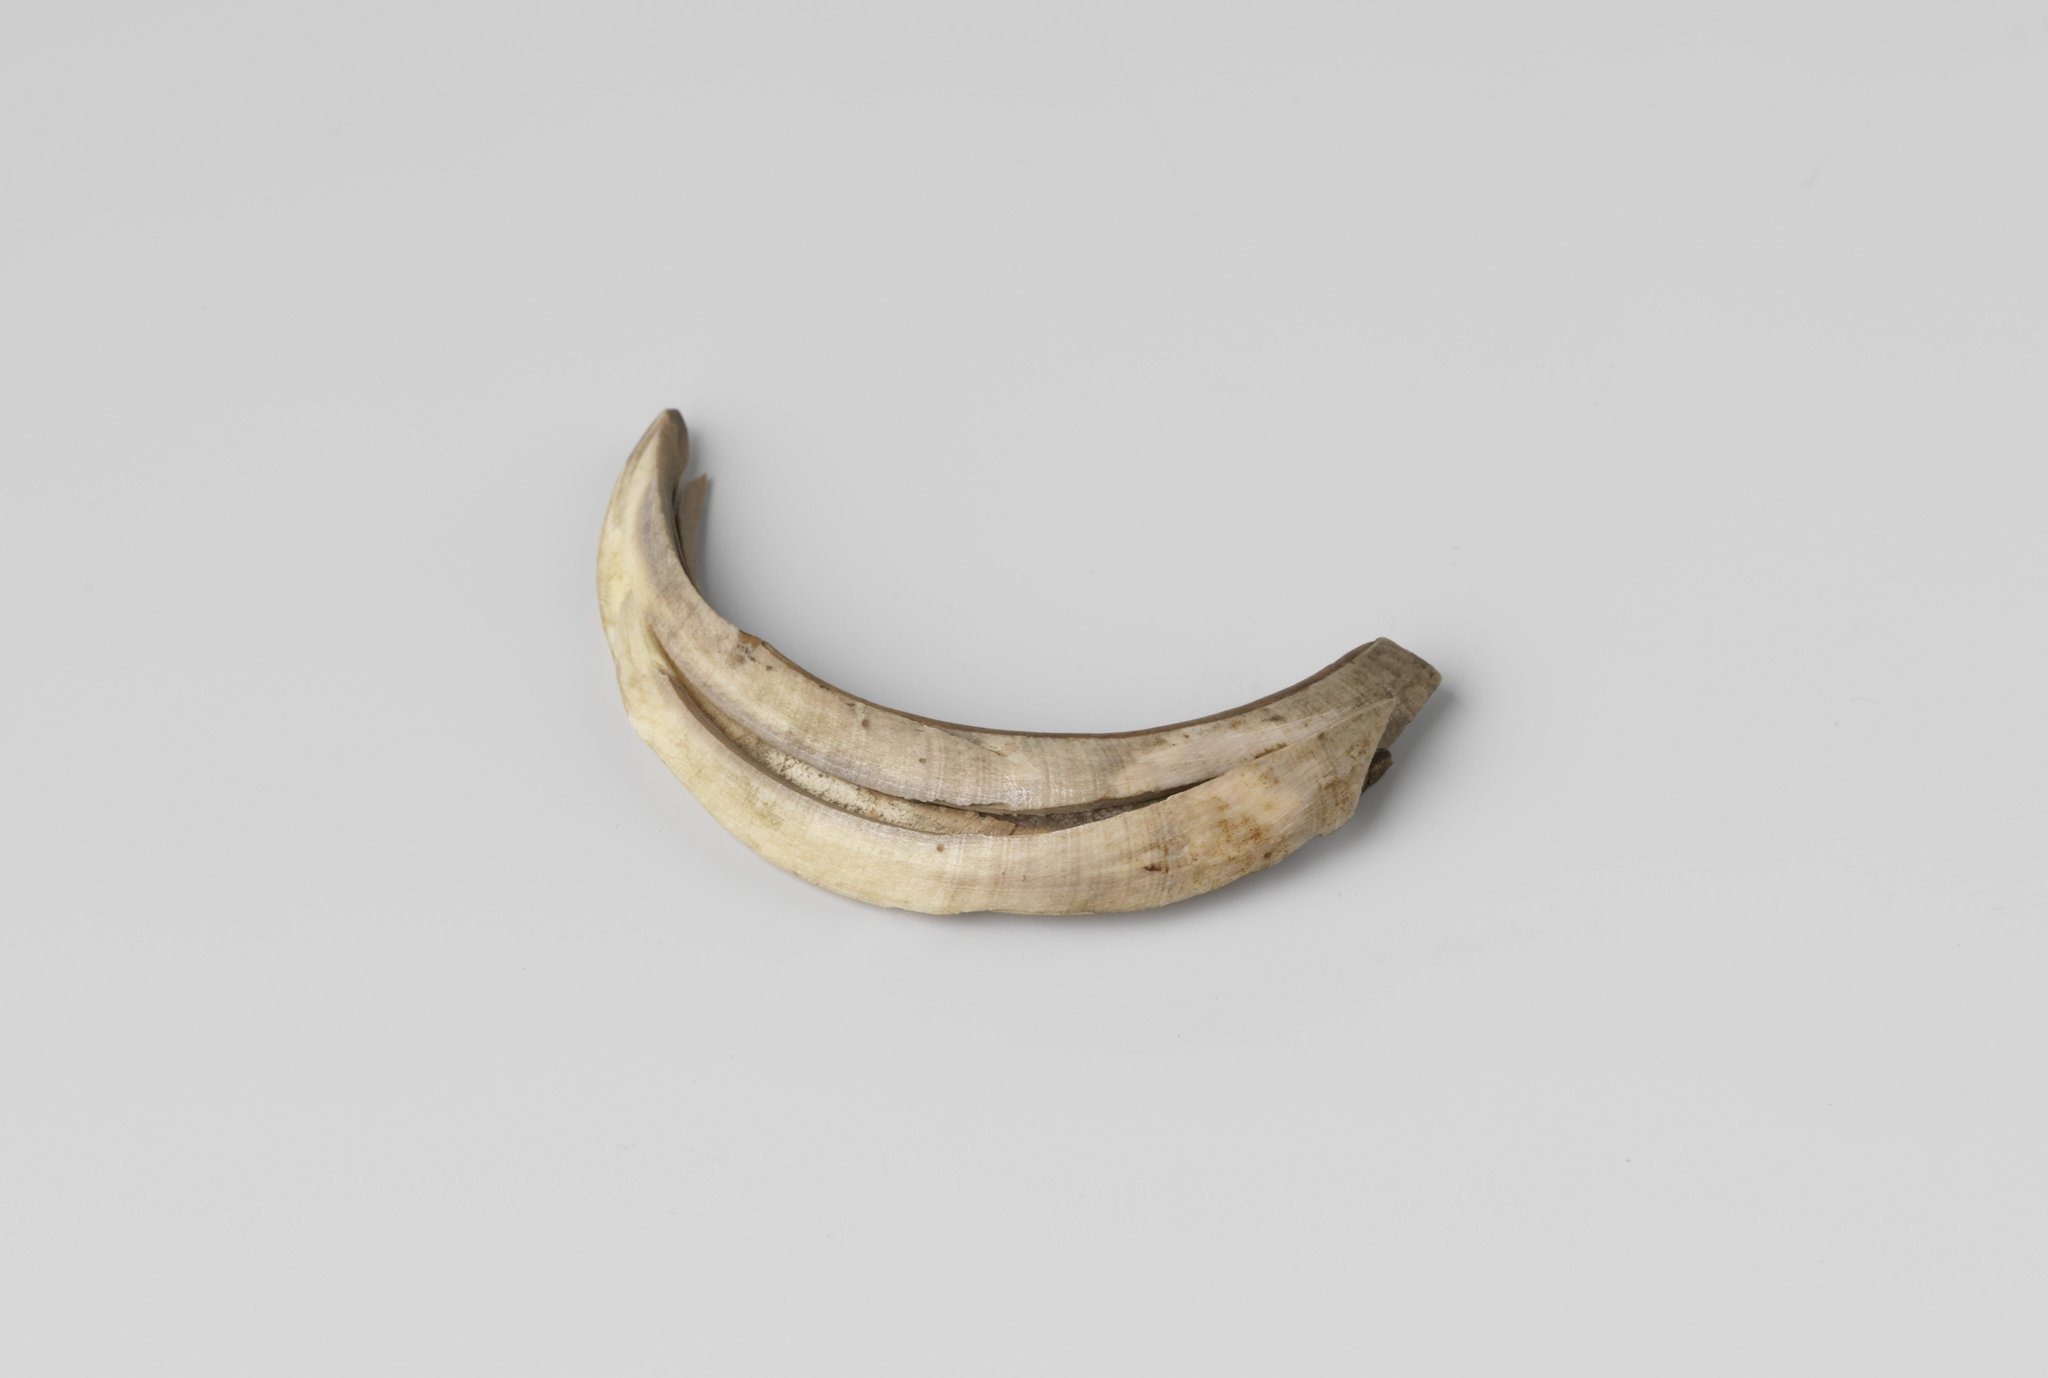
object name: tusk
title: Slagtand van een wild zwijn, gevonden in 1724 bij werkzaamheden in de Hillegommerbeek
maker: Anonymous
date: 1724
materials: ivory, pigment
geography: netherlands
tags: hillegom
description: Behorend tot drie hertshoornen en twee slagtanden van een wild zwijn (NG-NM-1392-1 t/m NG-NM-1392-5).